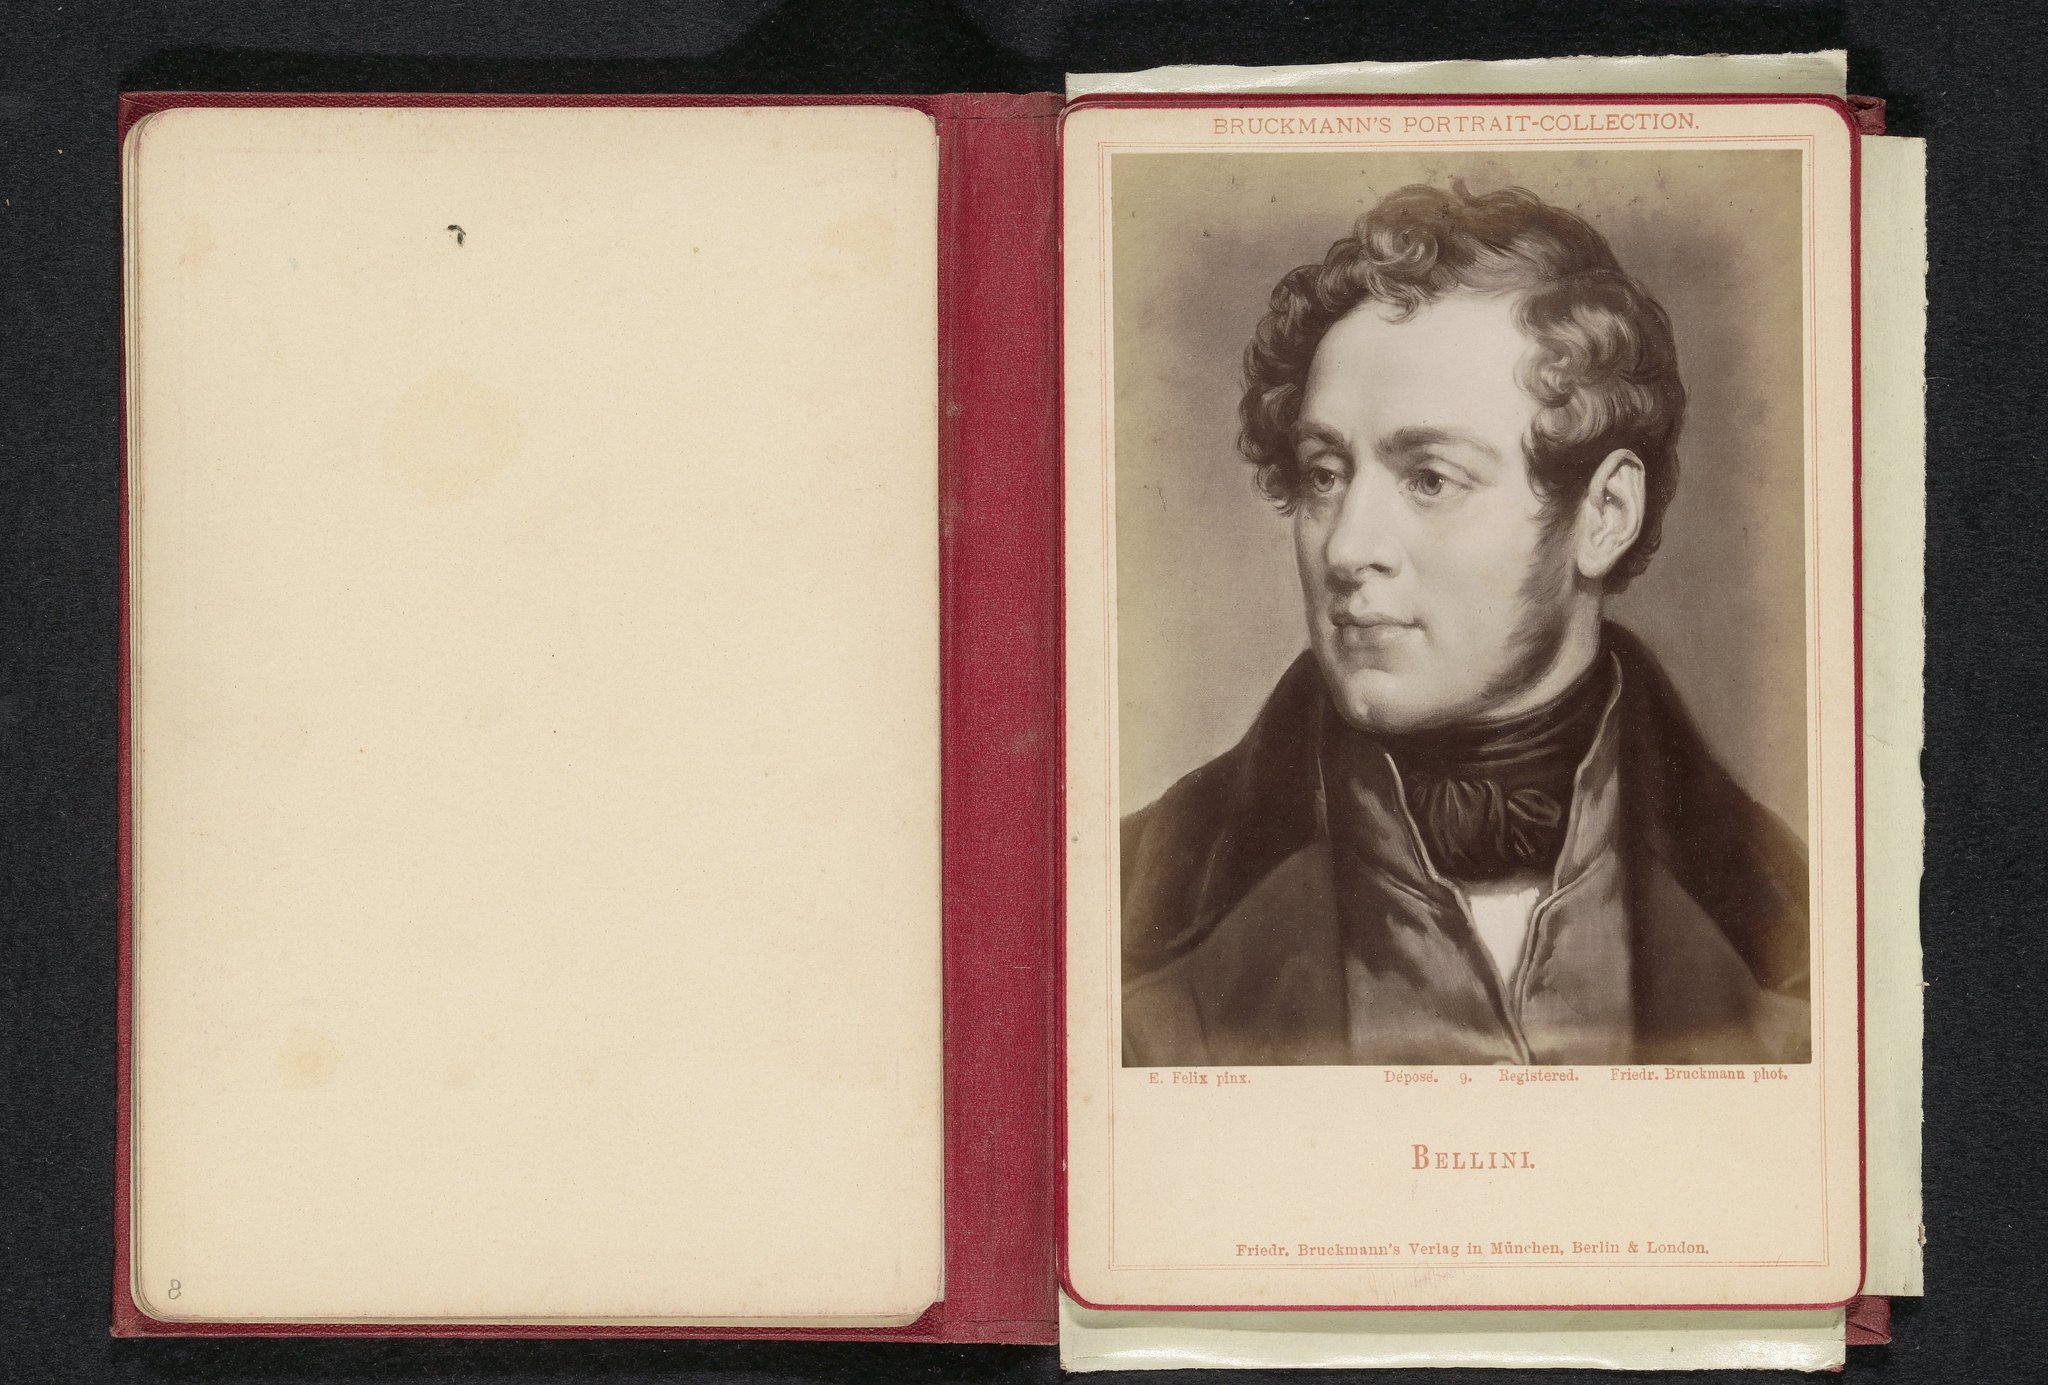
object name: photograph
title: Bruckmann's Portrait-Collection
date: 1868-1878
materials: photographic support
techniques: albumen print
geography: germany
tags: portrait of composer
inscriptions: number: ‘9.’